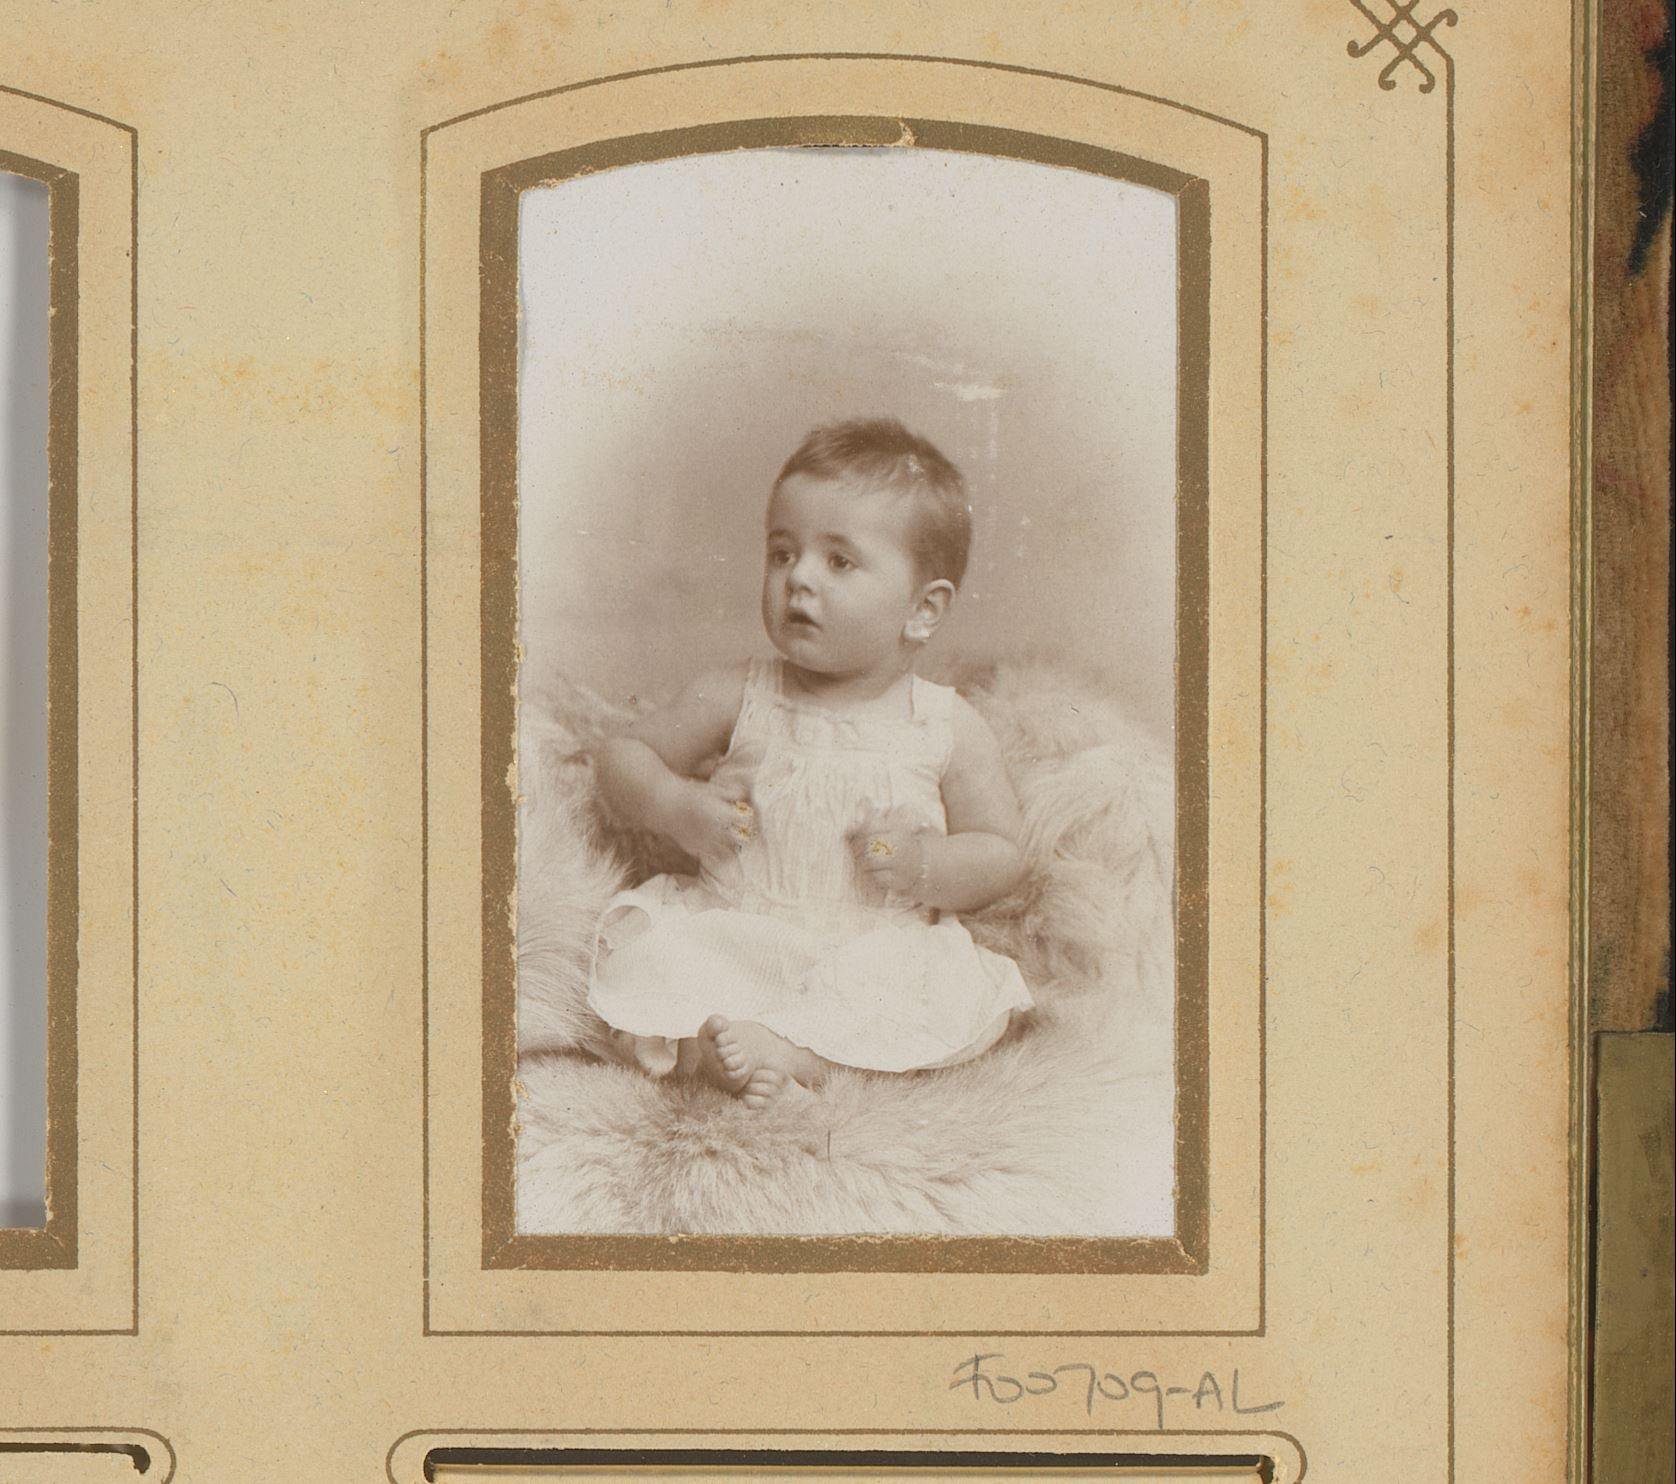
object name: album leaf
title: Portret van een zittende baby in witte jurk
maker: Anonymous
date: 1880-1910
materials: cardboard, photographic support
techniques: collodion silver print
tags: infant, baby